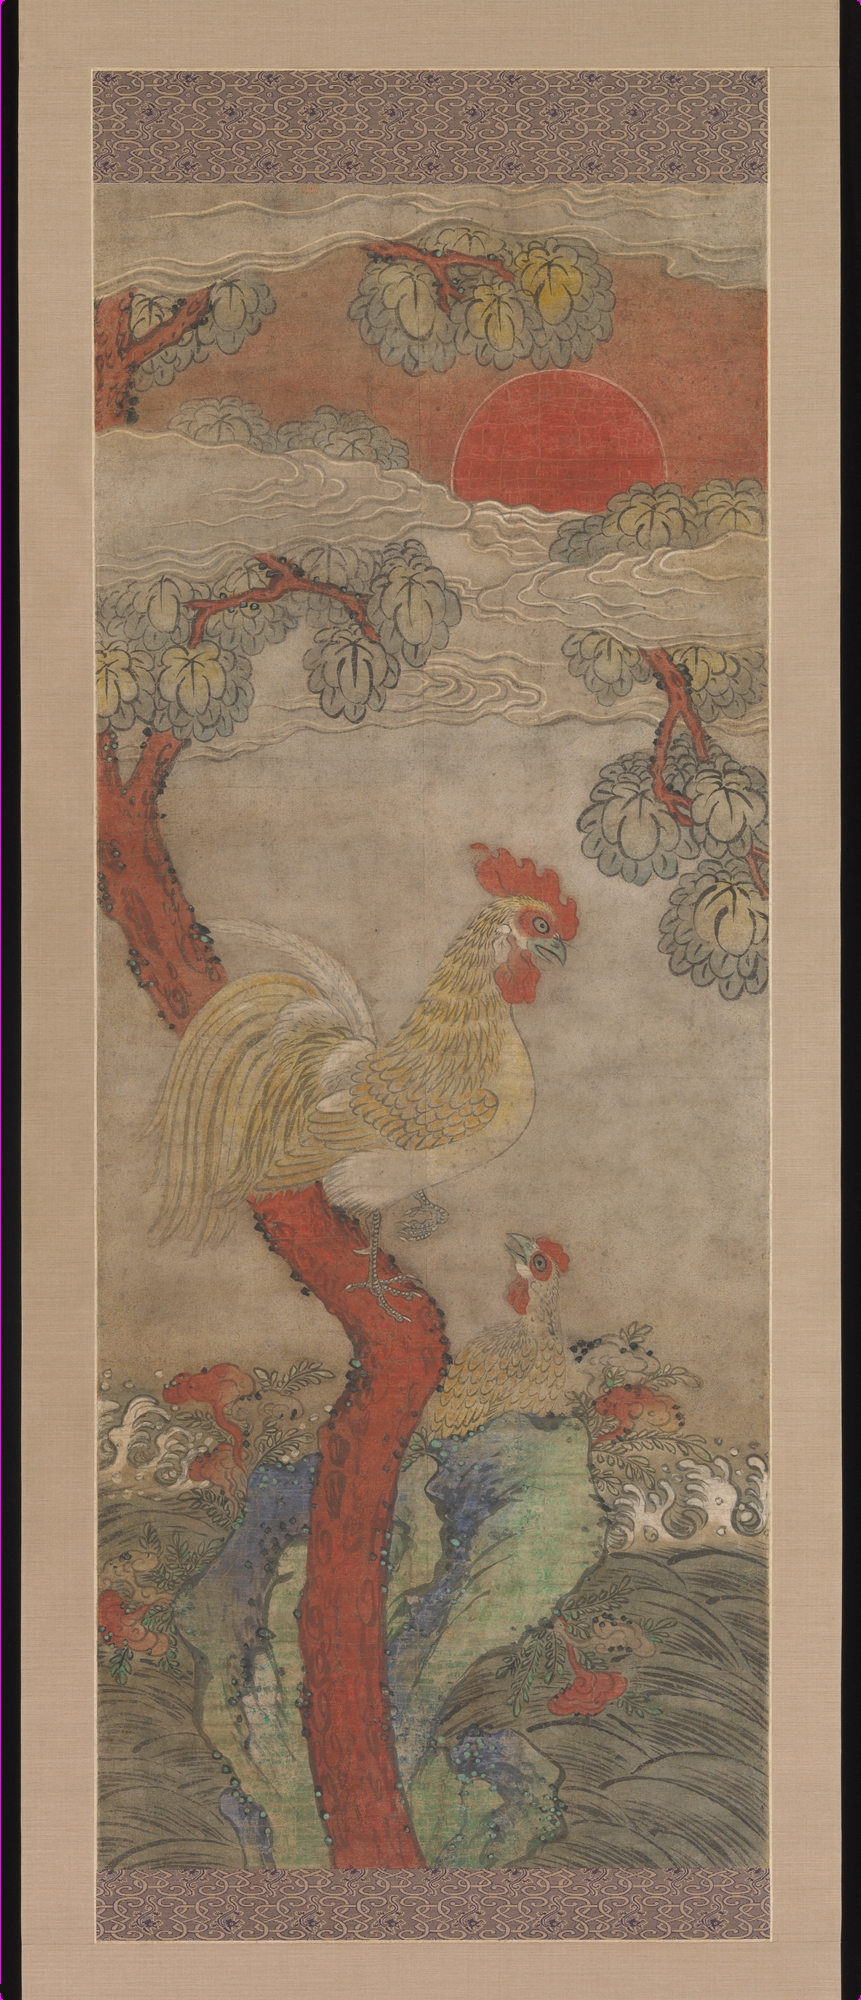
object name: hanging scroll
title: Golden Rooster and Hen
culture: korean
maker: unidentified artist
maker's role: artist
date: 1801-1900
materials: ink, paper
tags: roosters,trees,hens